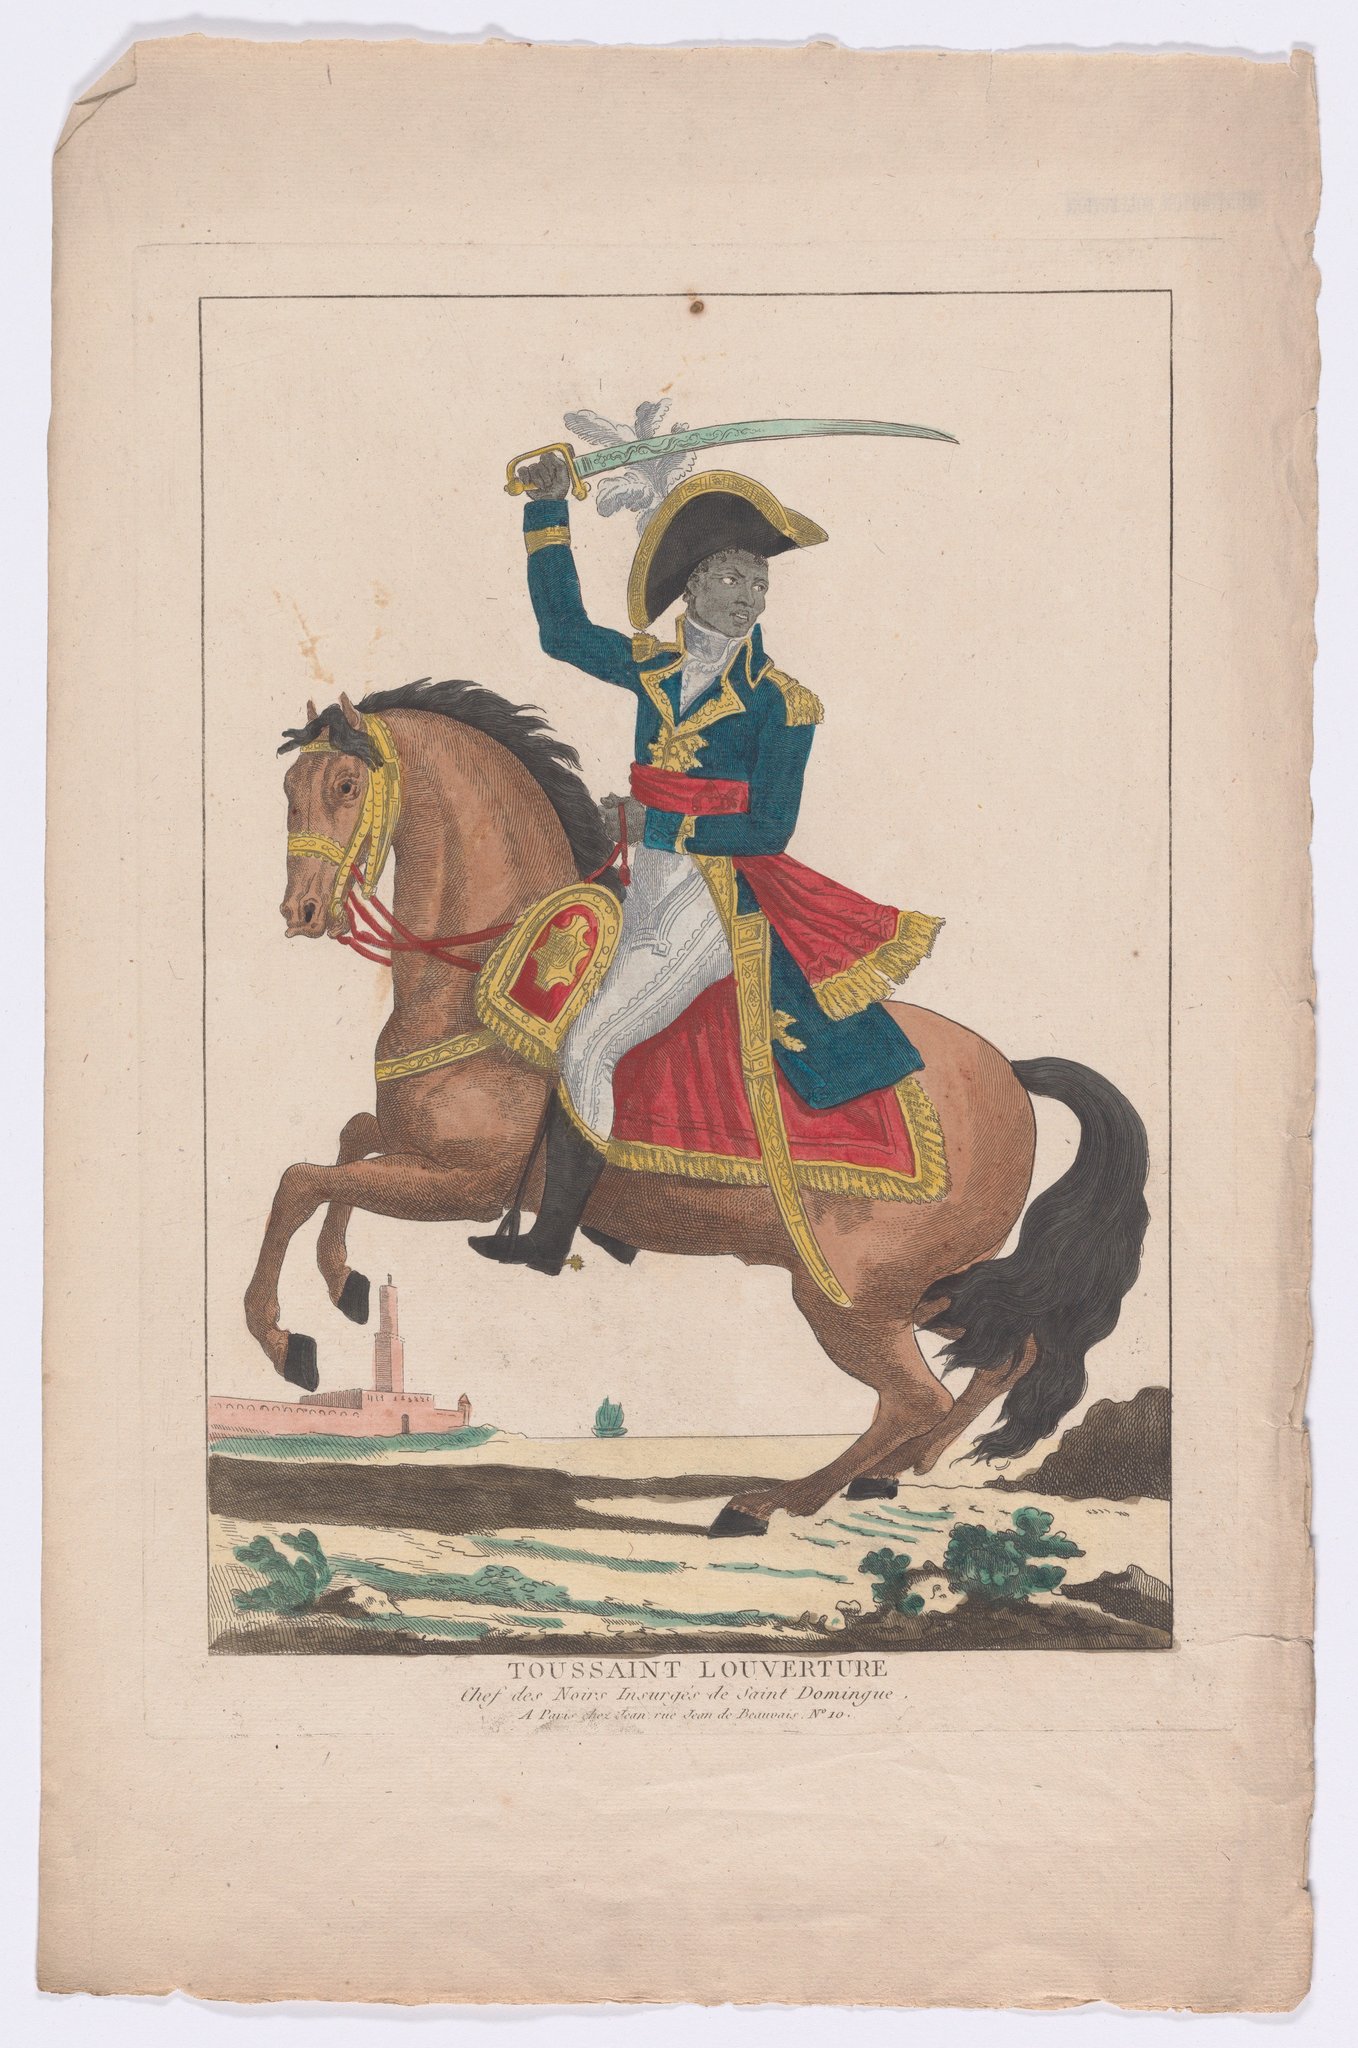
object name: print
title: Toussaint Louverture on Horseback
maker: anonymous, french, 19th century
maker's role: artist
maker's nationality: french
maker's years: 1800-1900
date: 1802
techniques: etching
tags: swords,men,horses